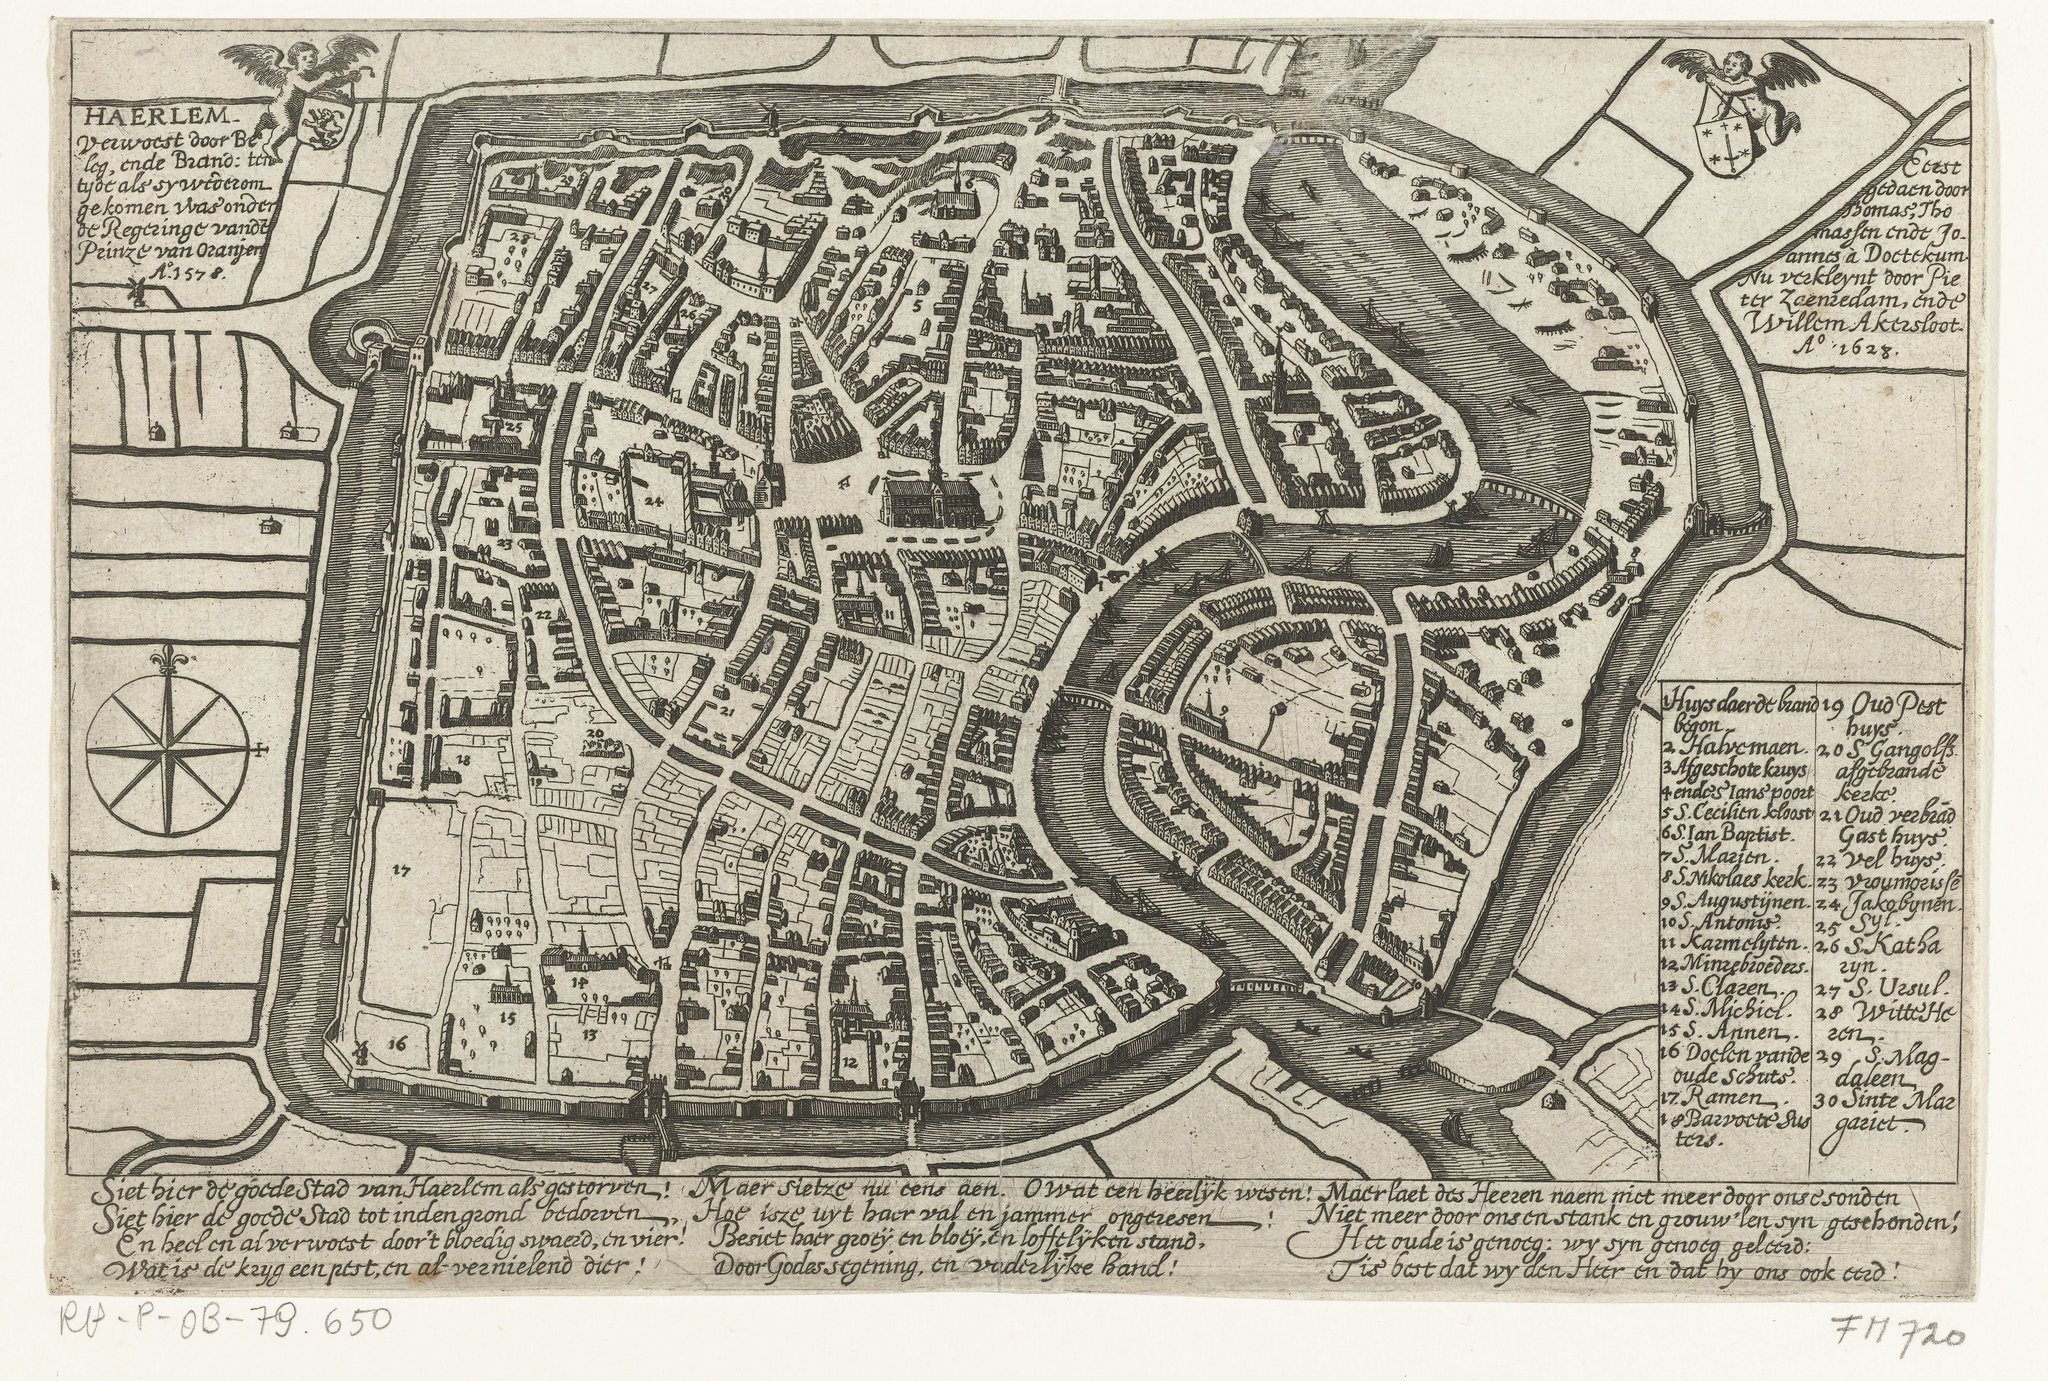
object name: print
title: Plattegrond van Haarlem met de verwoestingen na het beleg en de grote brand van 1576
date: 1628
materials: paper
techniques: engraving, etching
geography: haarlem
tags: on fire, ablaze, maps of cities, haarlem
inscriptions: date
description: Plattegrond van Haarlem met de verwoestingen in de stad na het beleg en de grote brand van 1576. Met onderschrift van 3 verzen van 4 regels in het Nederlands. Rechtsonder de legenda 1-30.